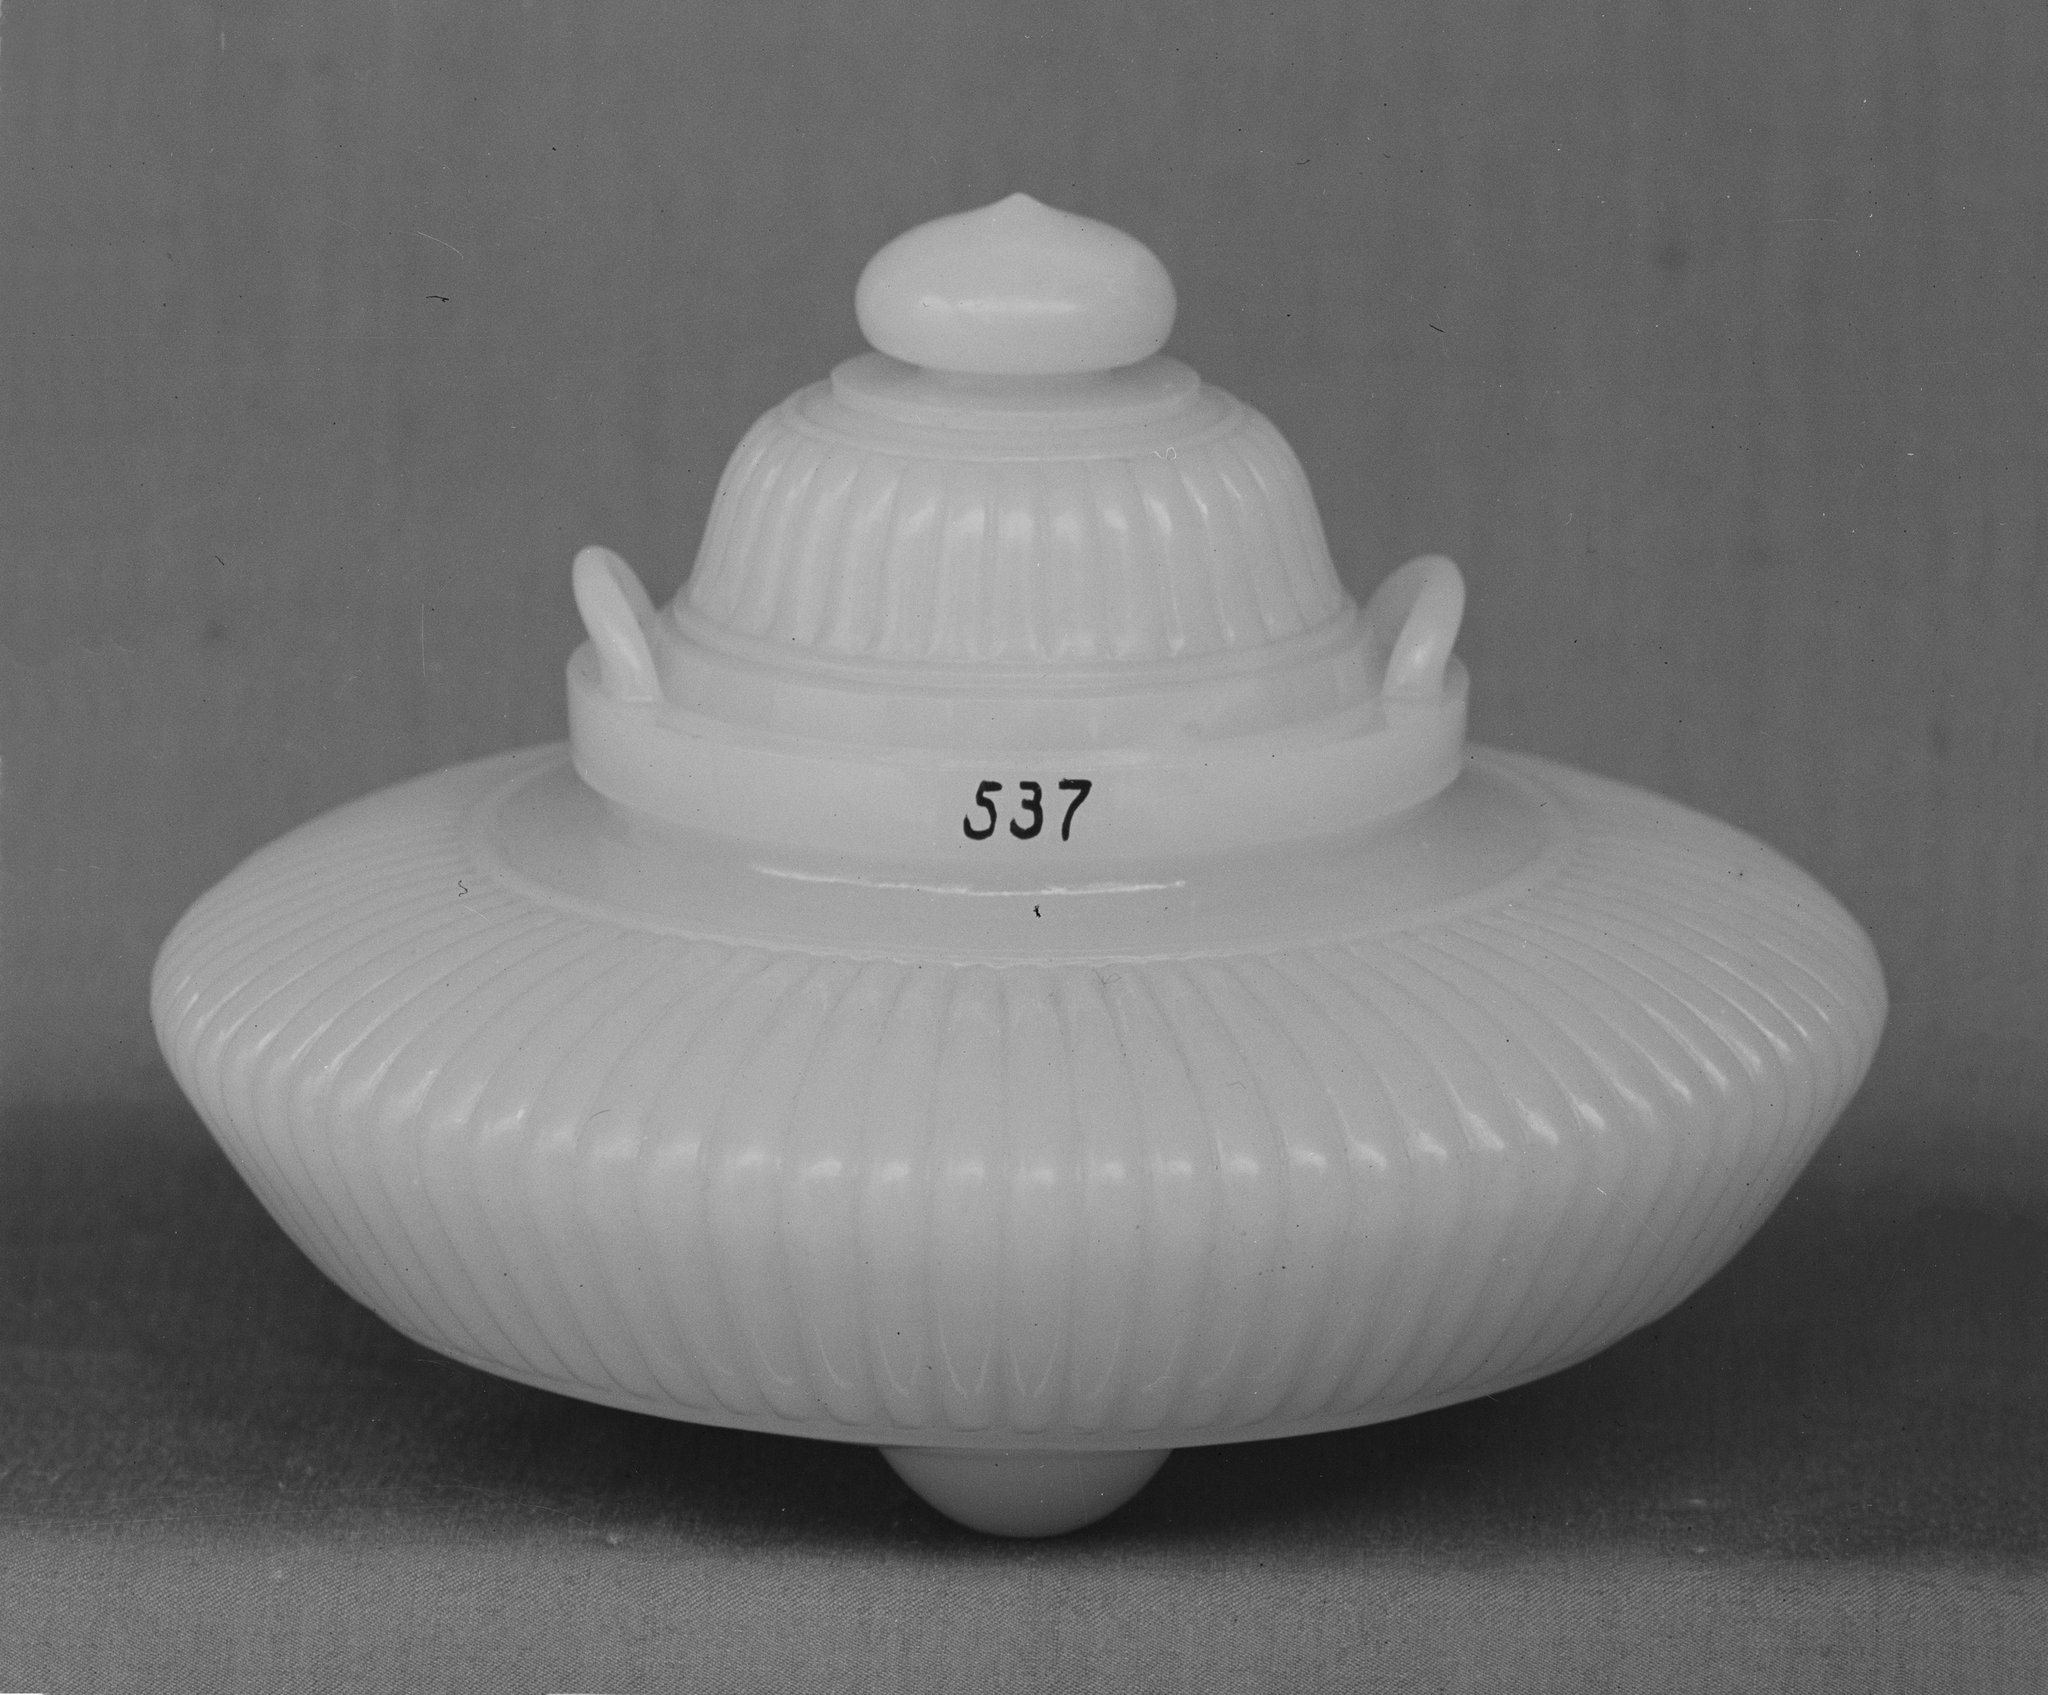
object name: incense burner with cover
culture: chinese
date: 1701-1800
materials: jade